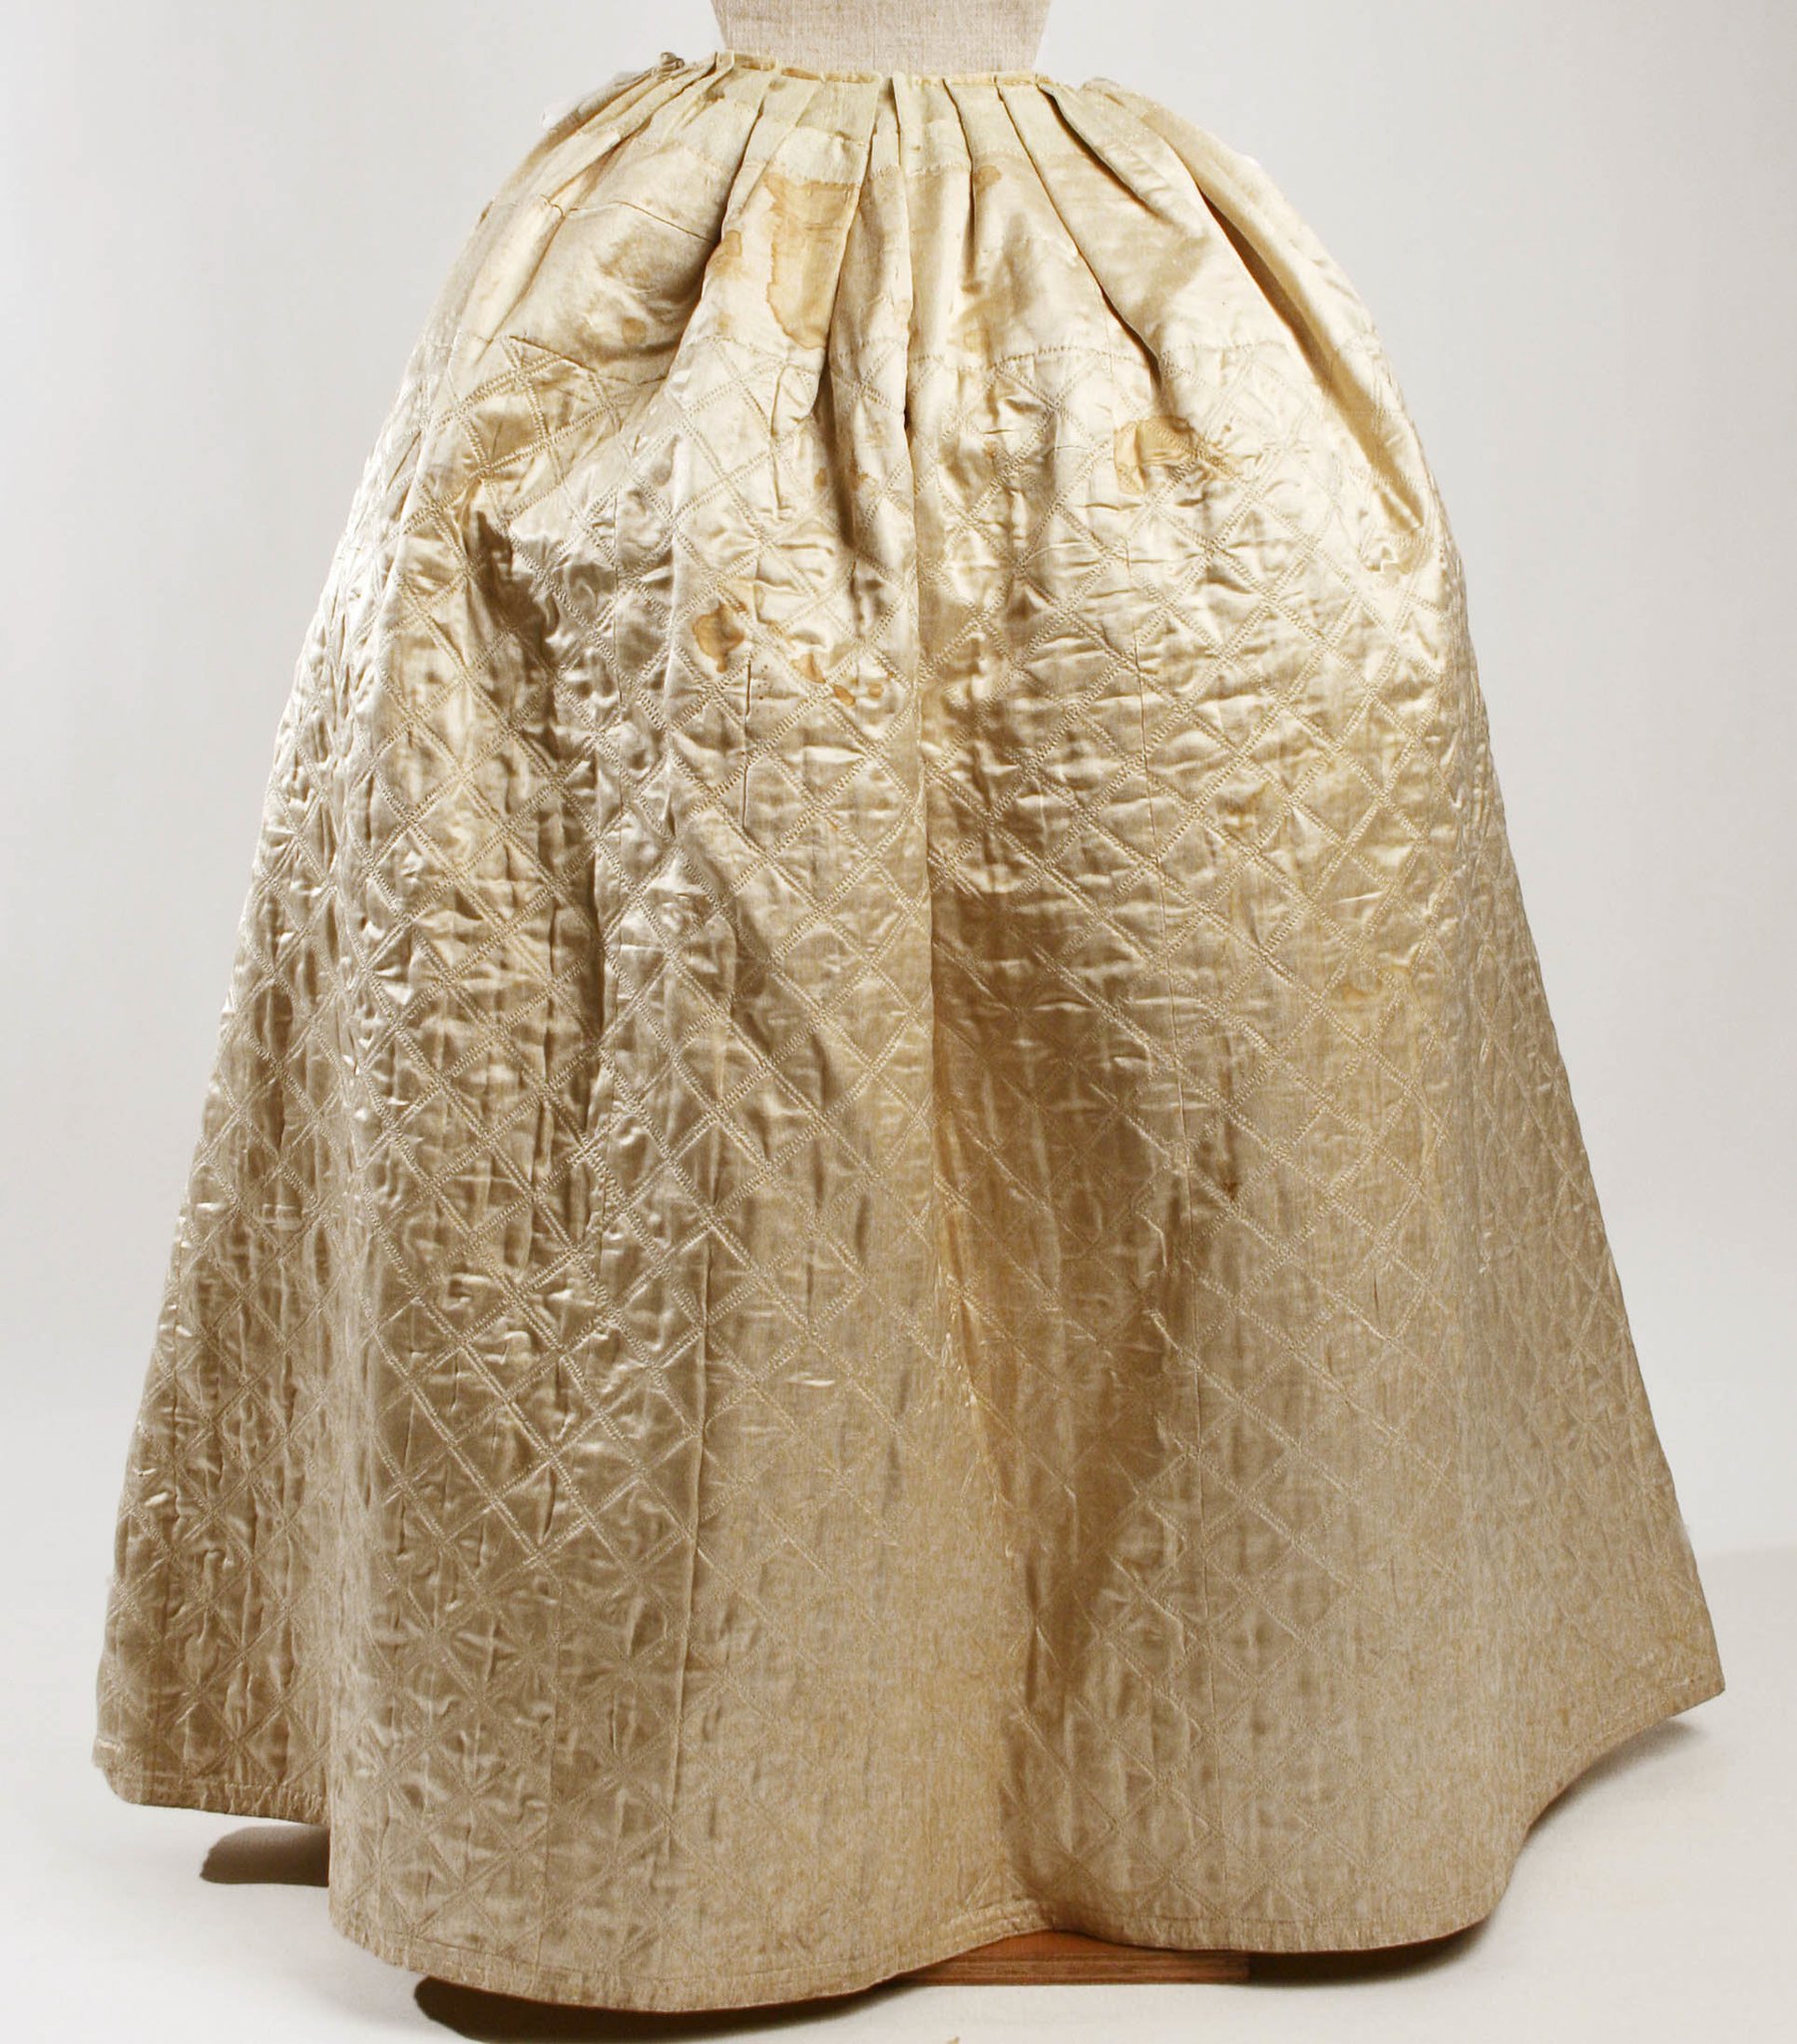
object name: petticoat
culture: european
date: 1701-1800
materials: silk